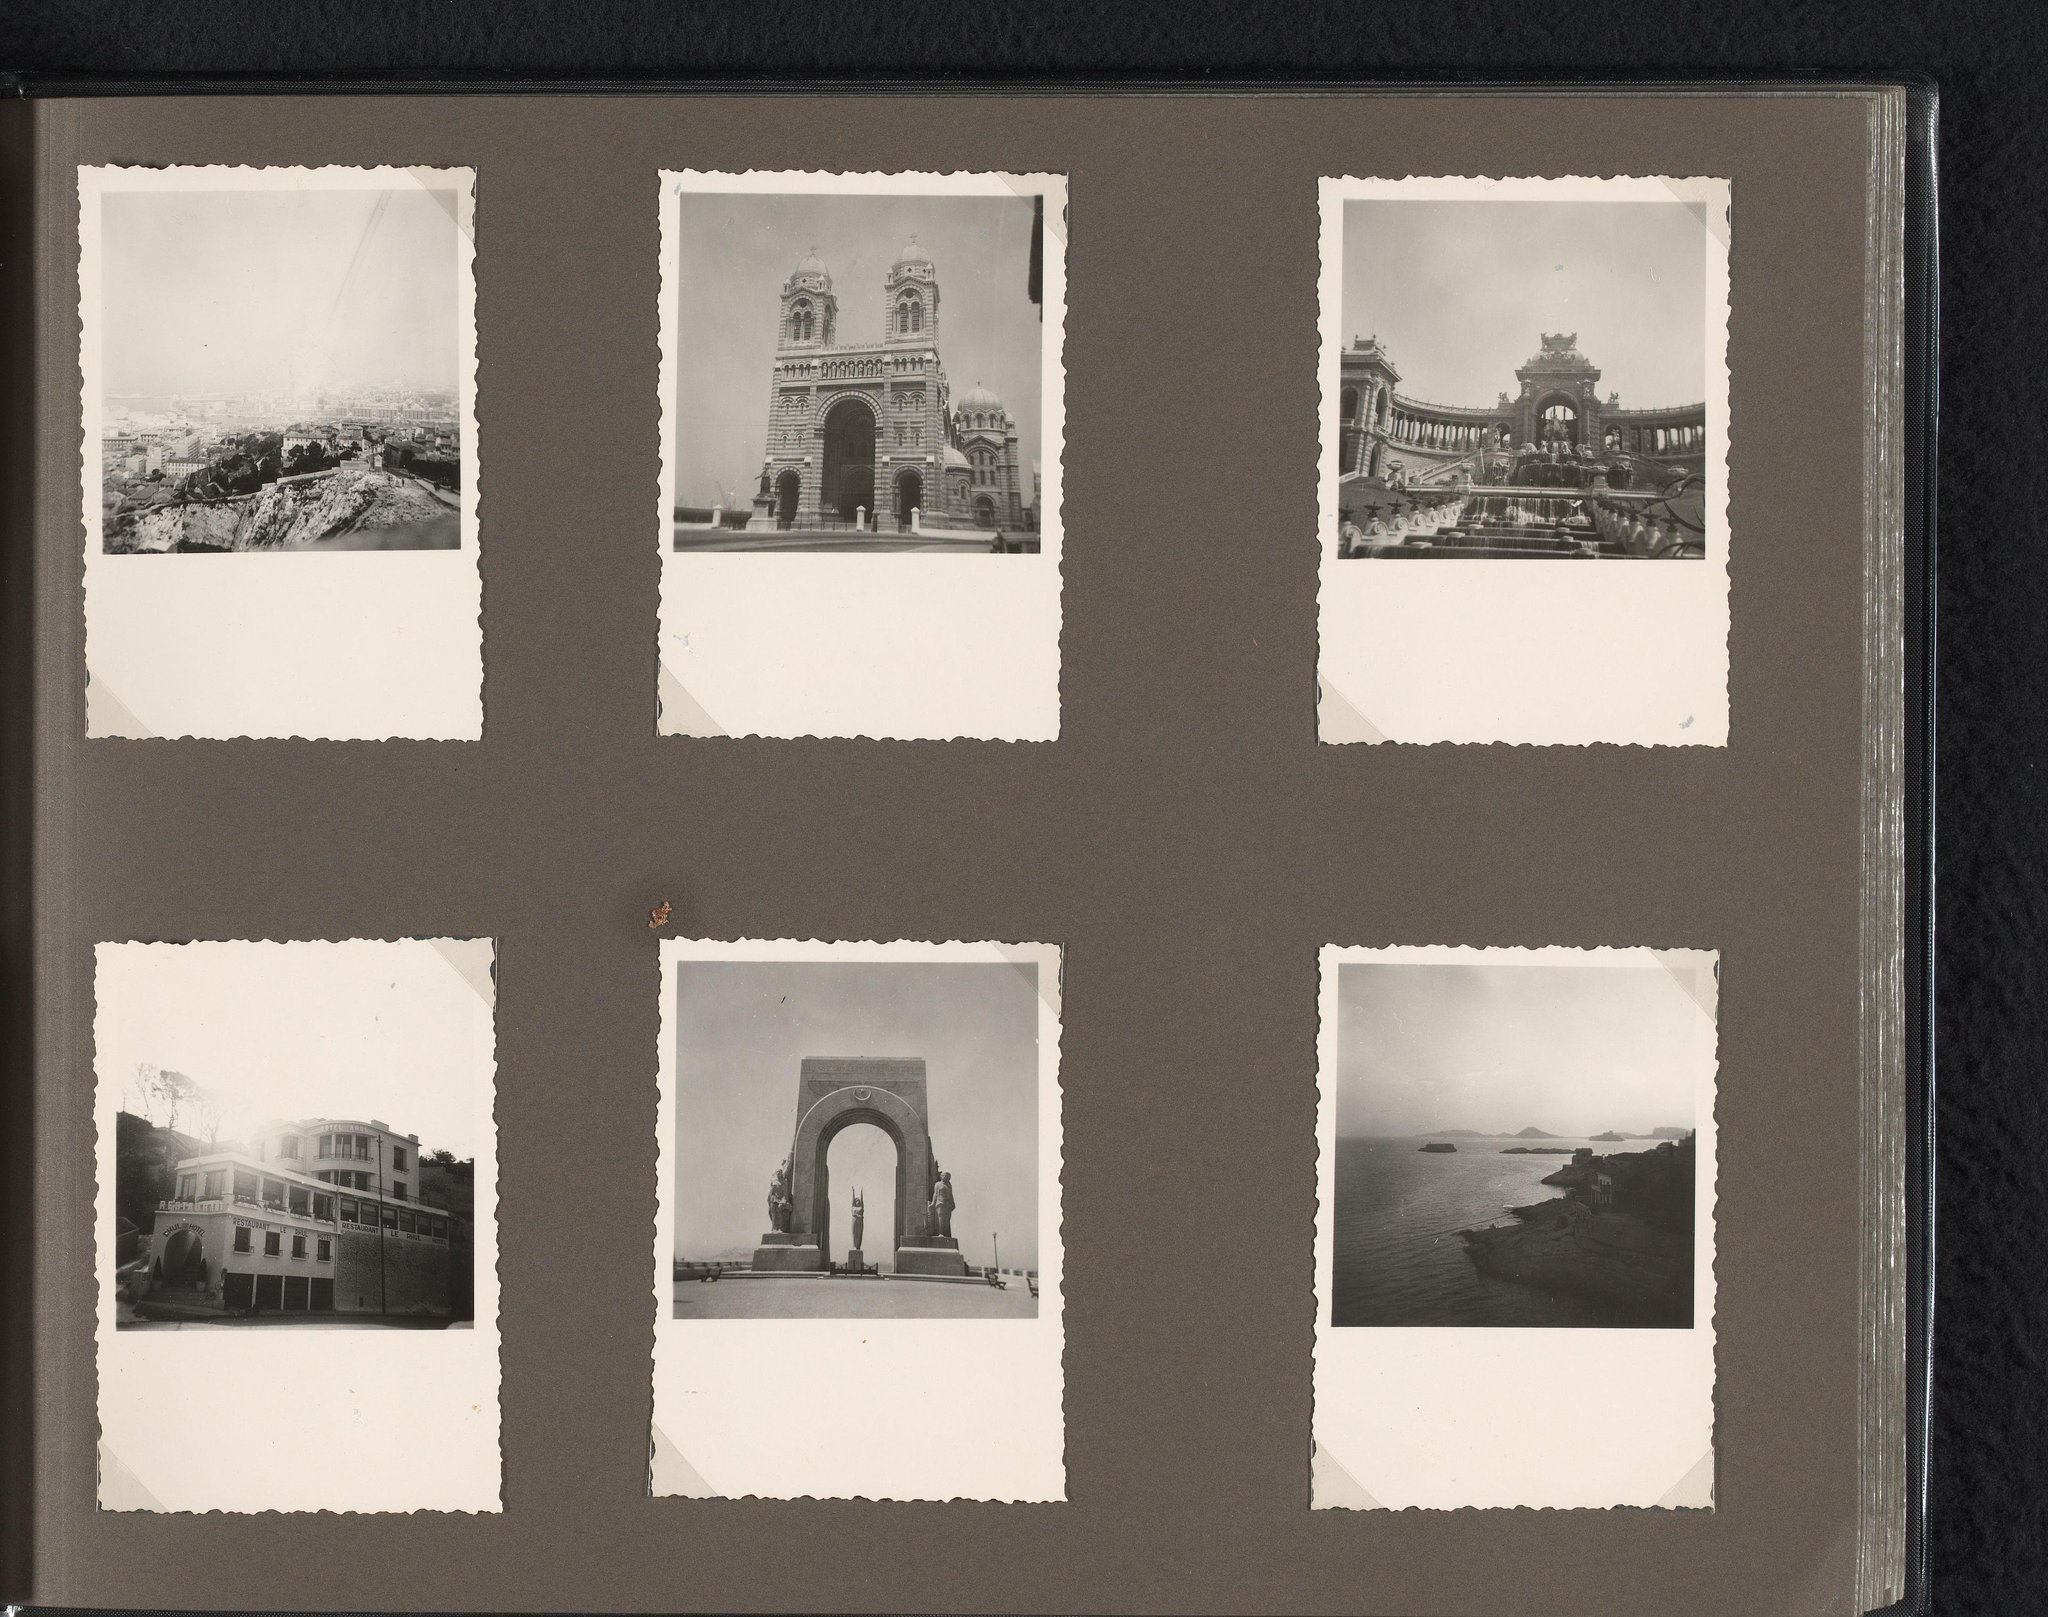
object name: photograph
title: Stadsgezichten in Marseille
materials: paper, cardboard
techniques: gelatin silver print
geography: marseille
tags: city-view, and landscape with man-made constructions, church (exterior), monument, statue, marseille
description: Blad bevat zes foto's, zonder personen. Deze foto's maken deel uit van een album.